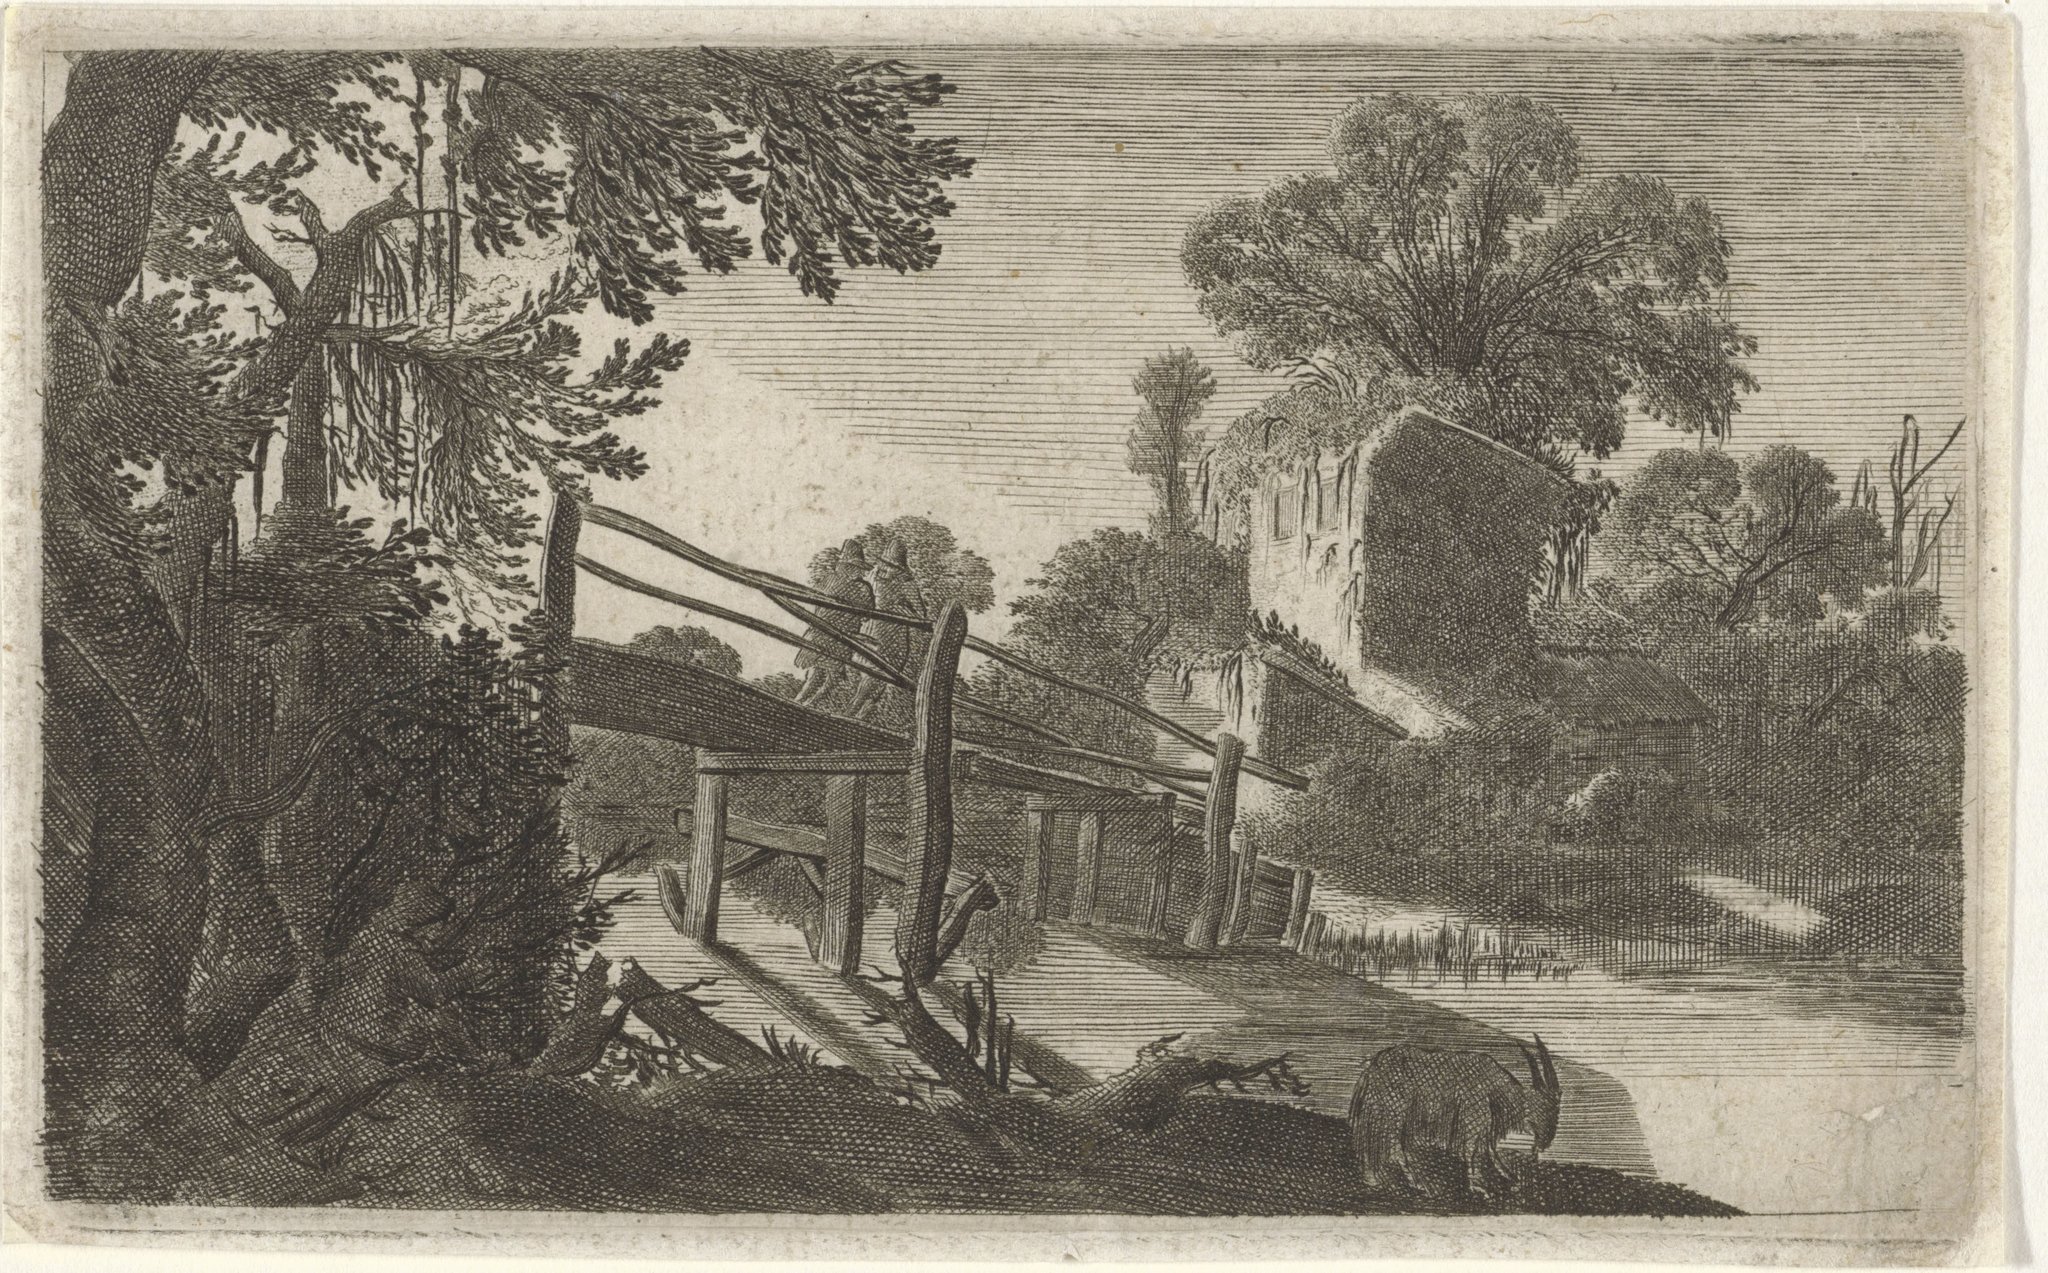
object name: print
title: Zes landschappen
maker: gillis van scheyndel (i)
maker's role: draughtsman, print maker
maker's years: 1595-1660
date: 1640-1653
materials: paper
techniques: engraving, etching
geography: netherlands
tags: landscape with ruins, bridge, goat, night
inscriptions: collector's mark: Lugt 2228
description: Boomrijk landschap met een houten brug, bij nacht. Op de voorgrond een geit en op de achtergrond een ruïne. De prent maakt deel uit van een serie van zes landschappen.